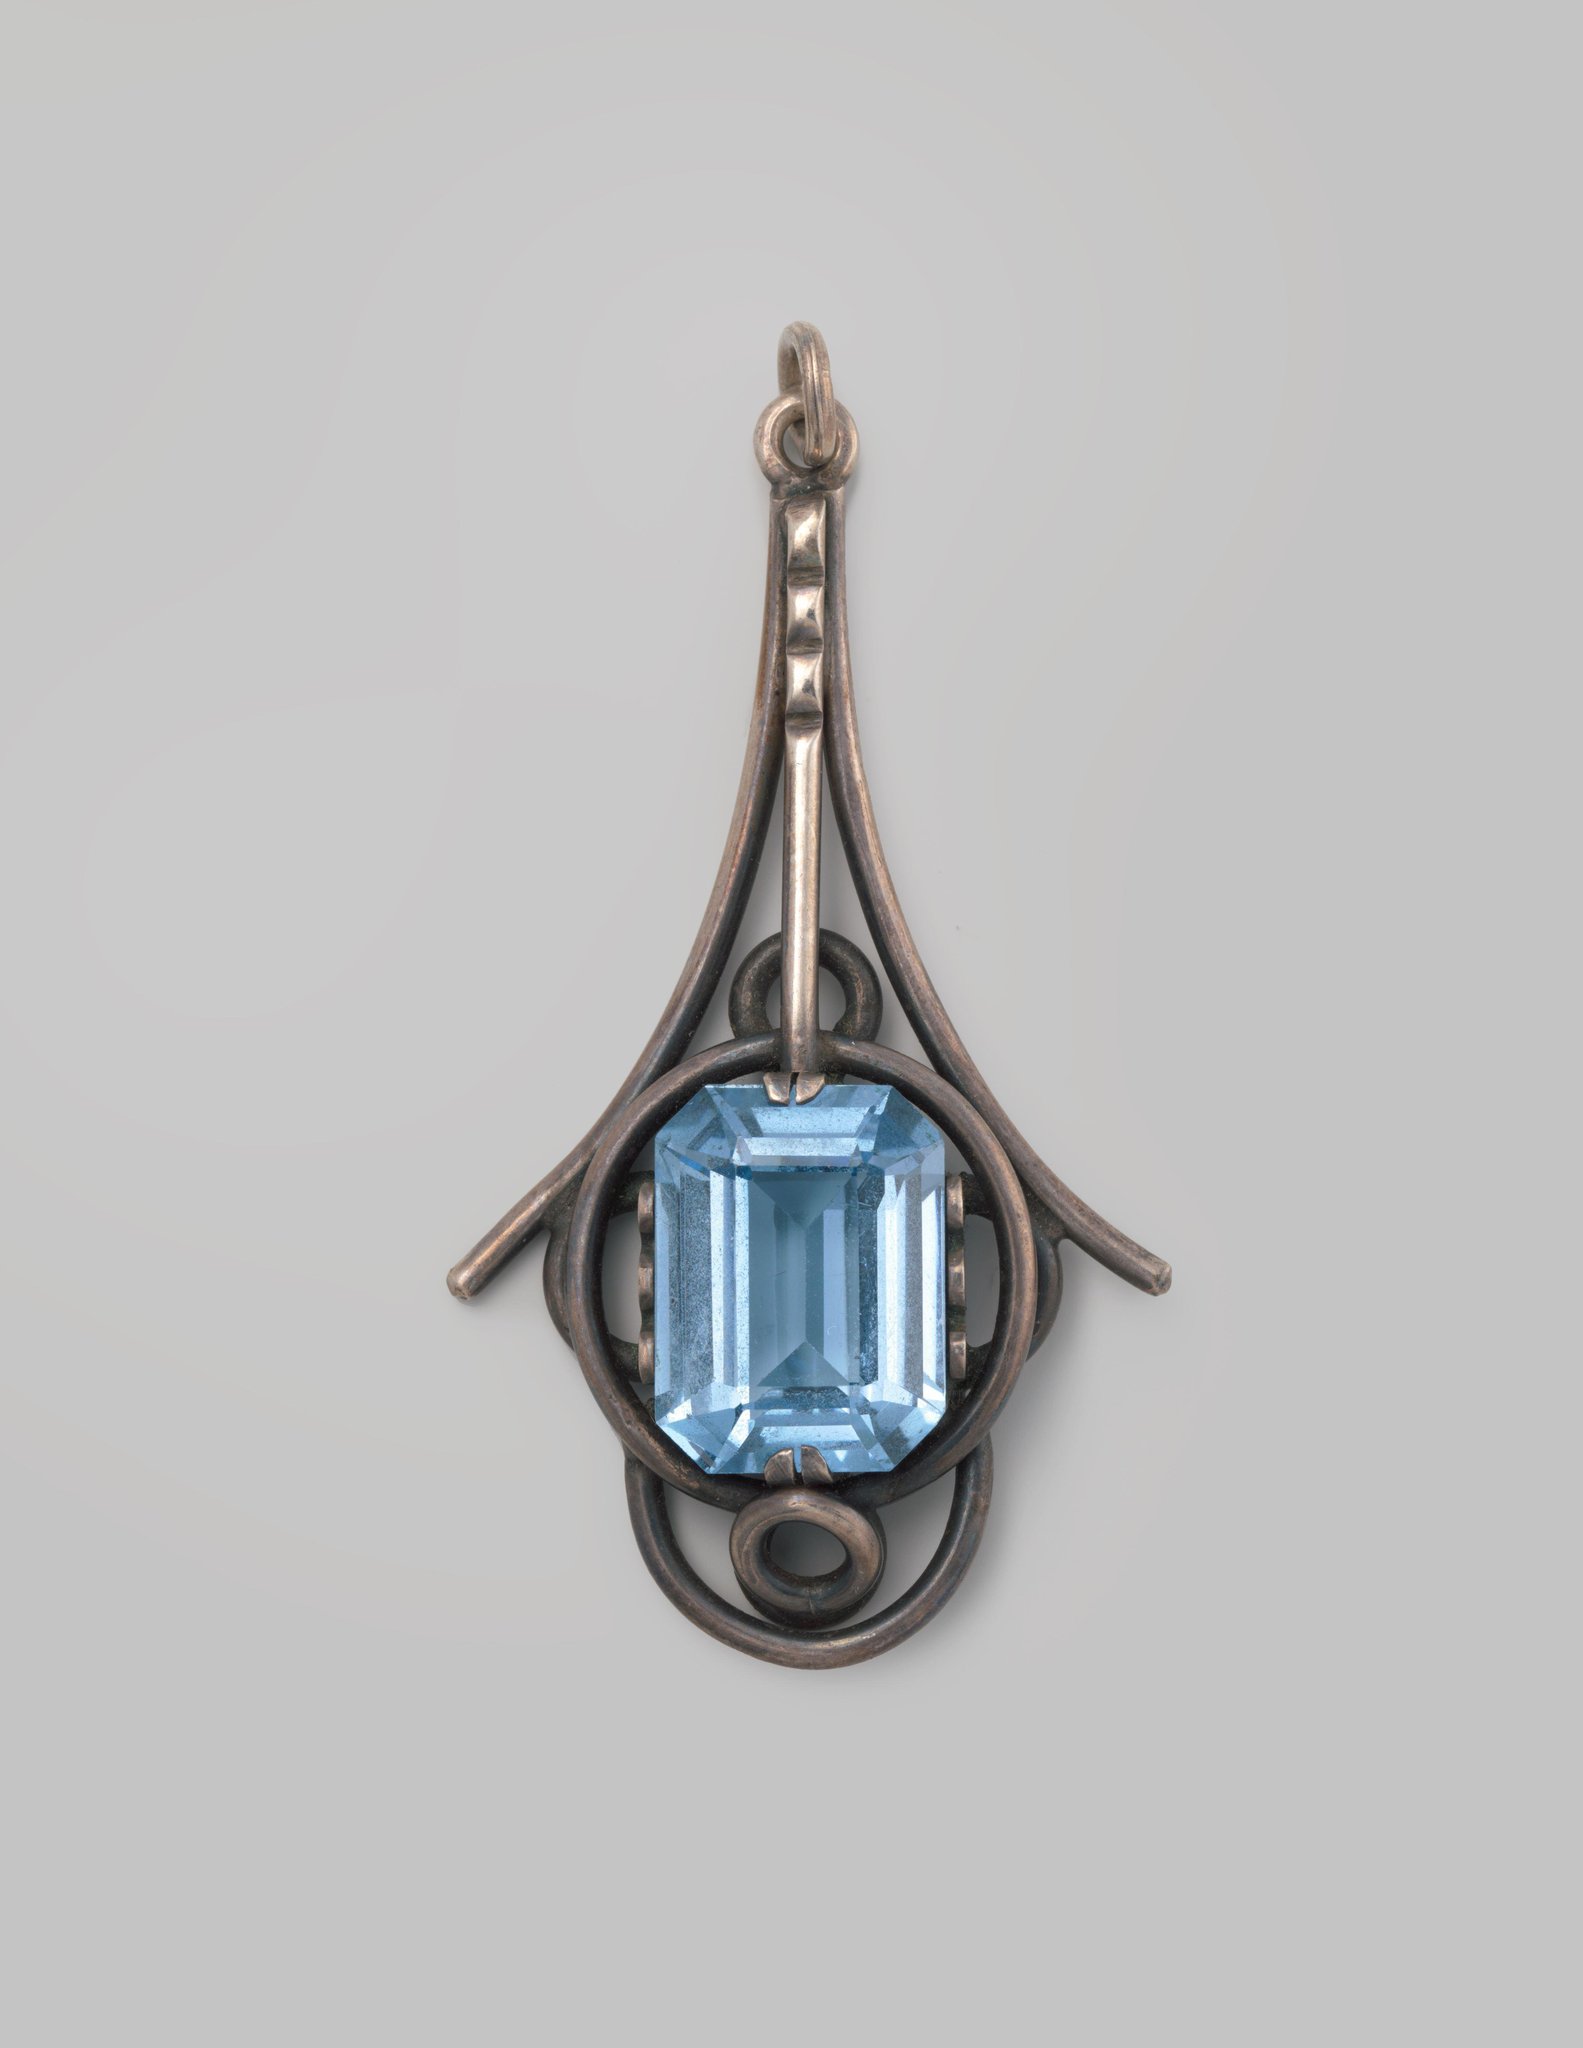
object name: pendant jewelry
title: Hanger van draadwerk in zilver met gefacetteerde blauwe synthetische spinel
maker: h.w. ouëndag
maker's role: jeweler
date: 1930-1950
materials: silver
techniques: faceting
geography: amsterdam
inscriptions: alloy mark: ‘oud zwaard’, maker's mark: ‘H2O’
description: Hanger van draadwerk in zilver met synthetische emeraude gefacetteerde blauwe spinel, voorzien van een draadoog.